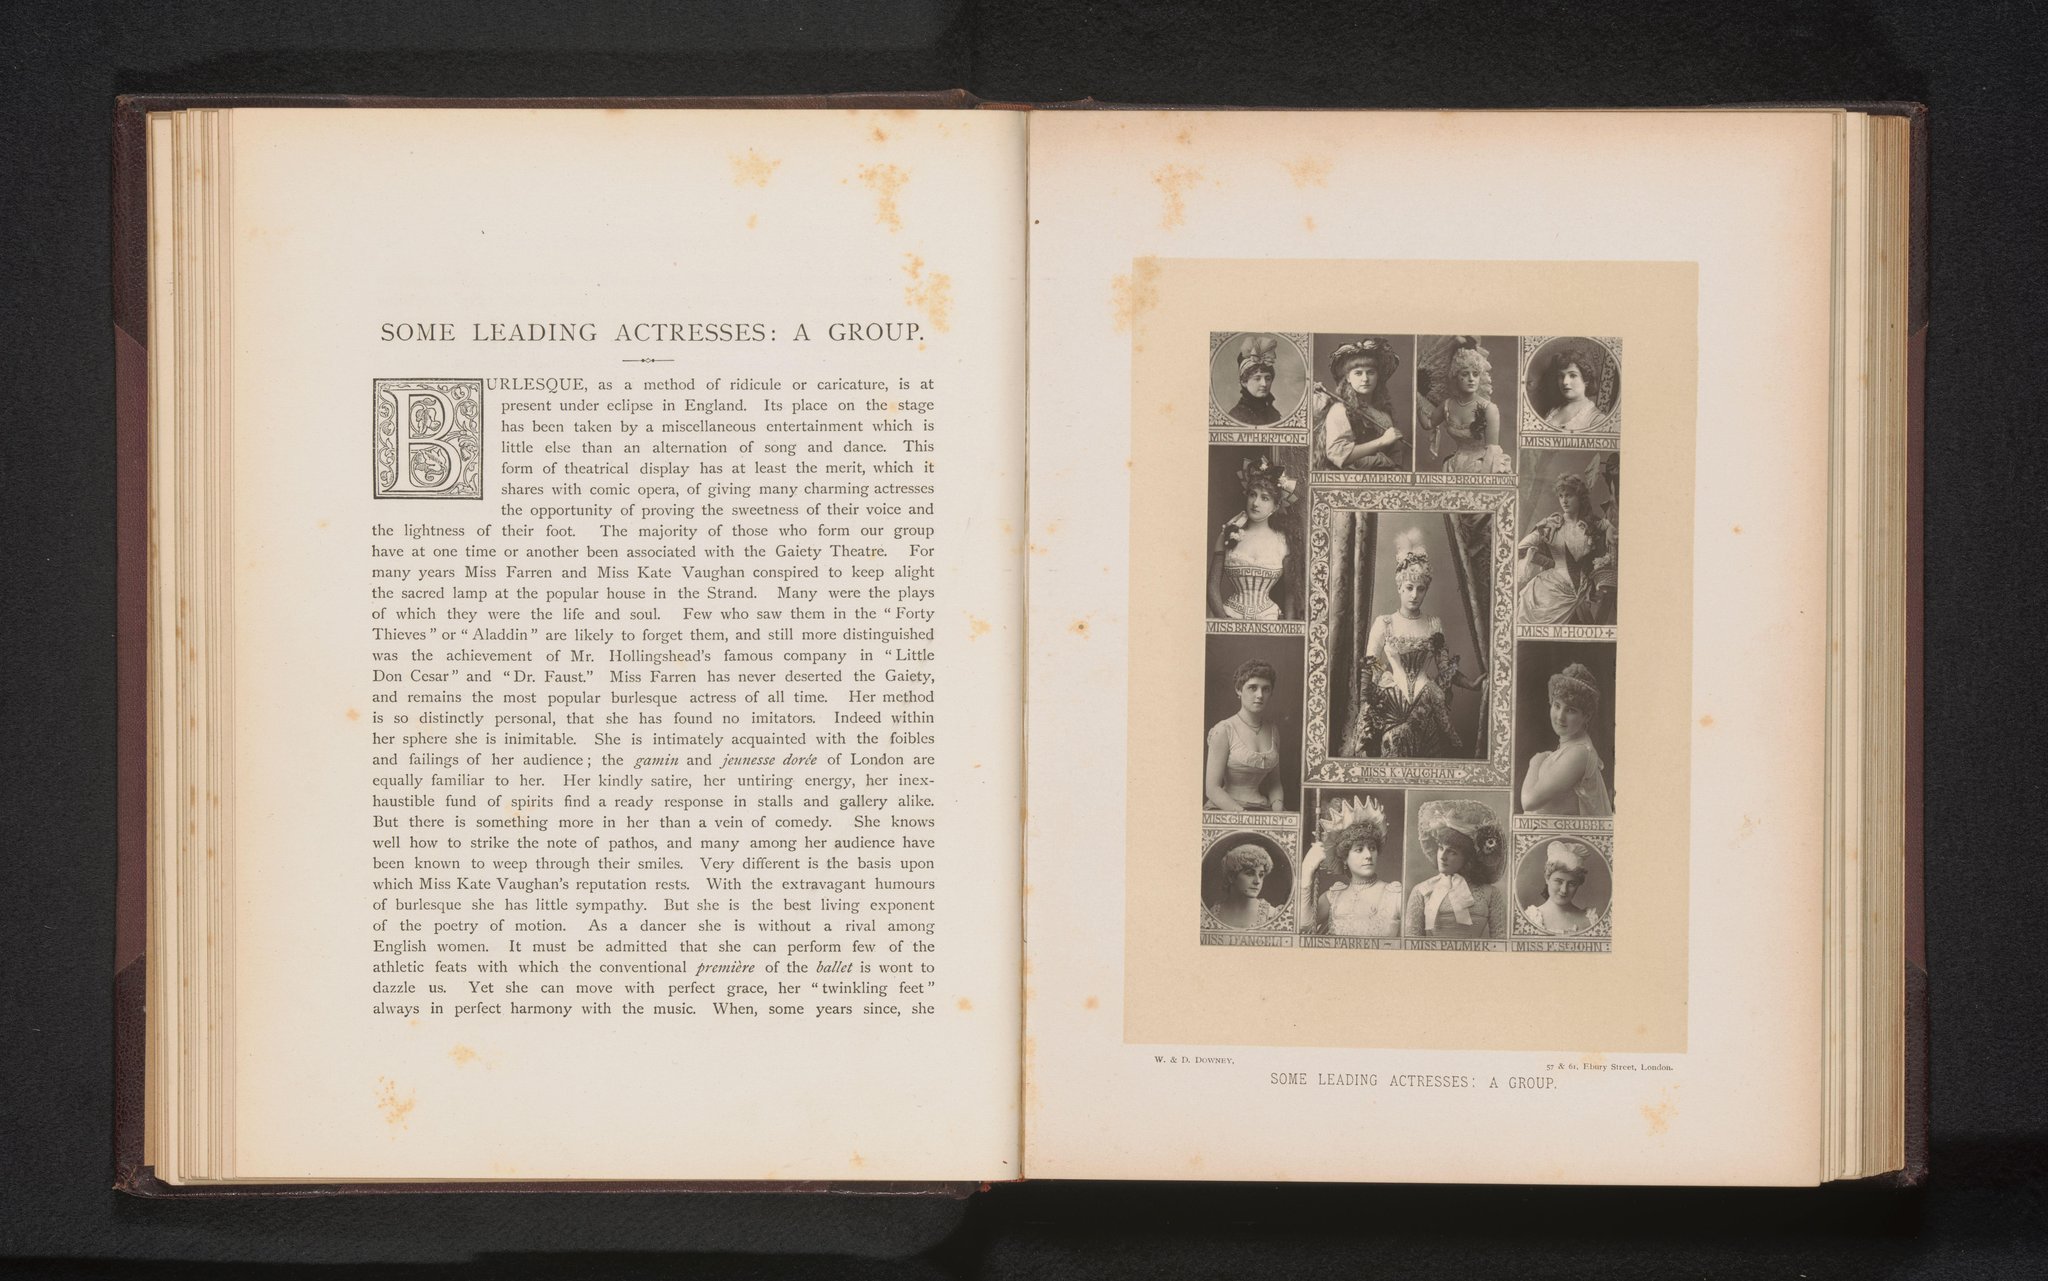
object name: page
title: Some Leading Actresses: a Group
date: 1885-1890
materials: paper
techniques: carbon print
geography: london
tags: portrait of actor, actress, anonymous historical persons portrayed in a group, in a group-portrait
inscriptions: address: ‘57 & 61, Ebury Street, London.’